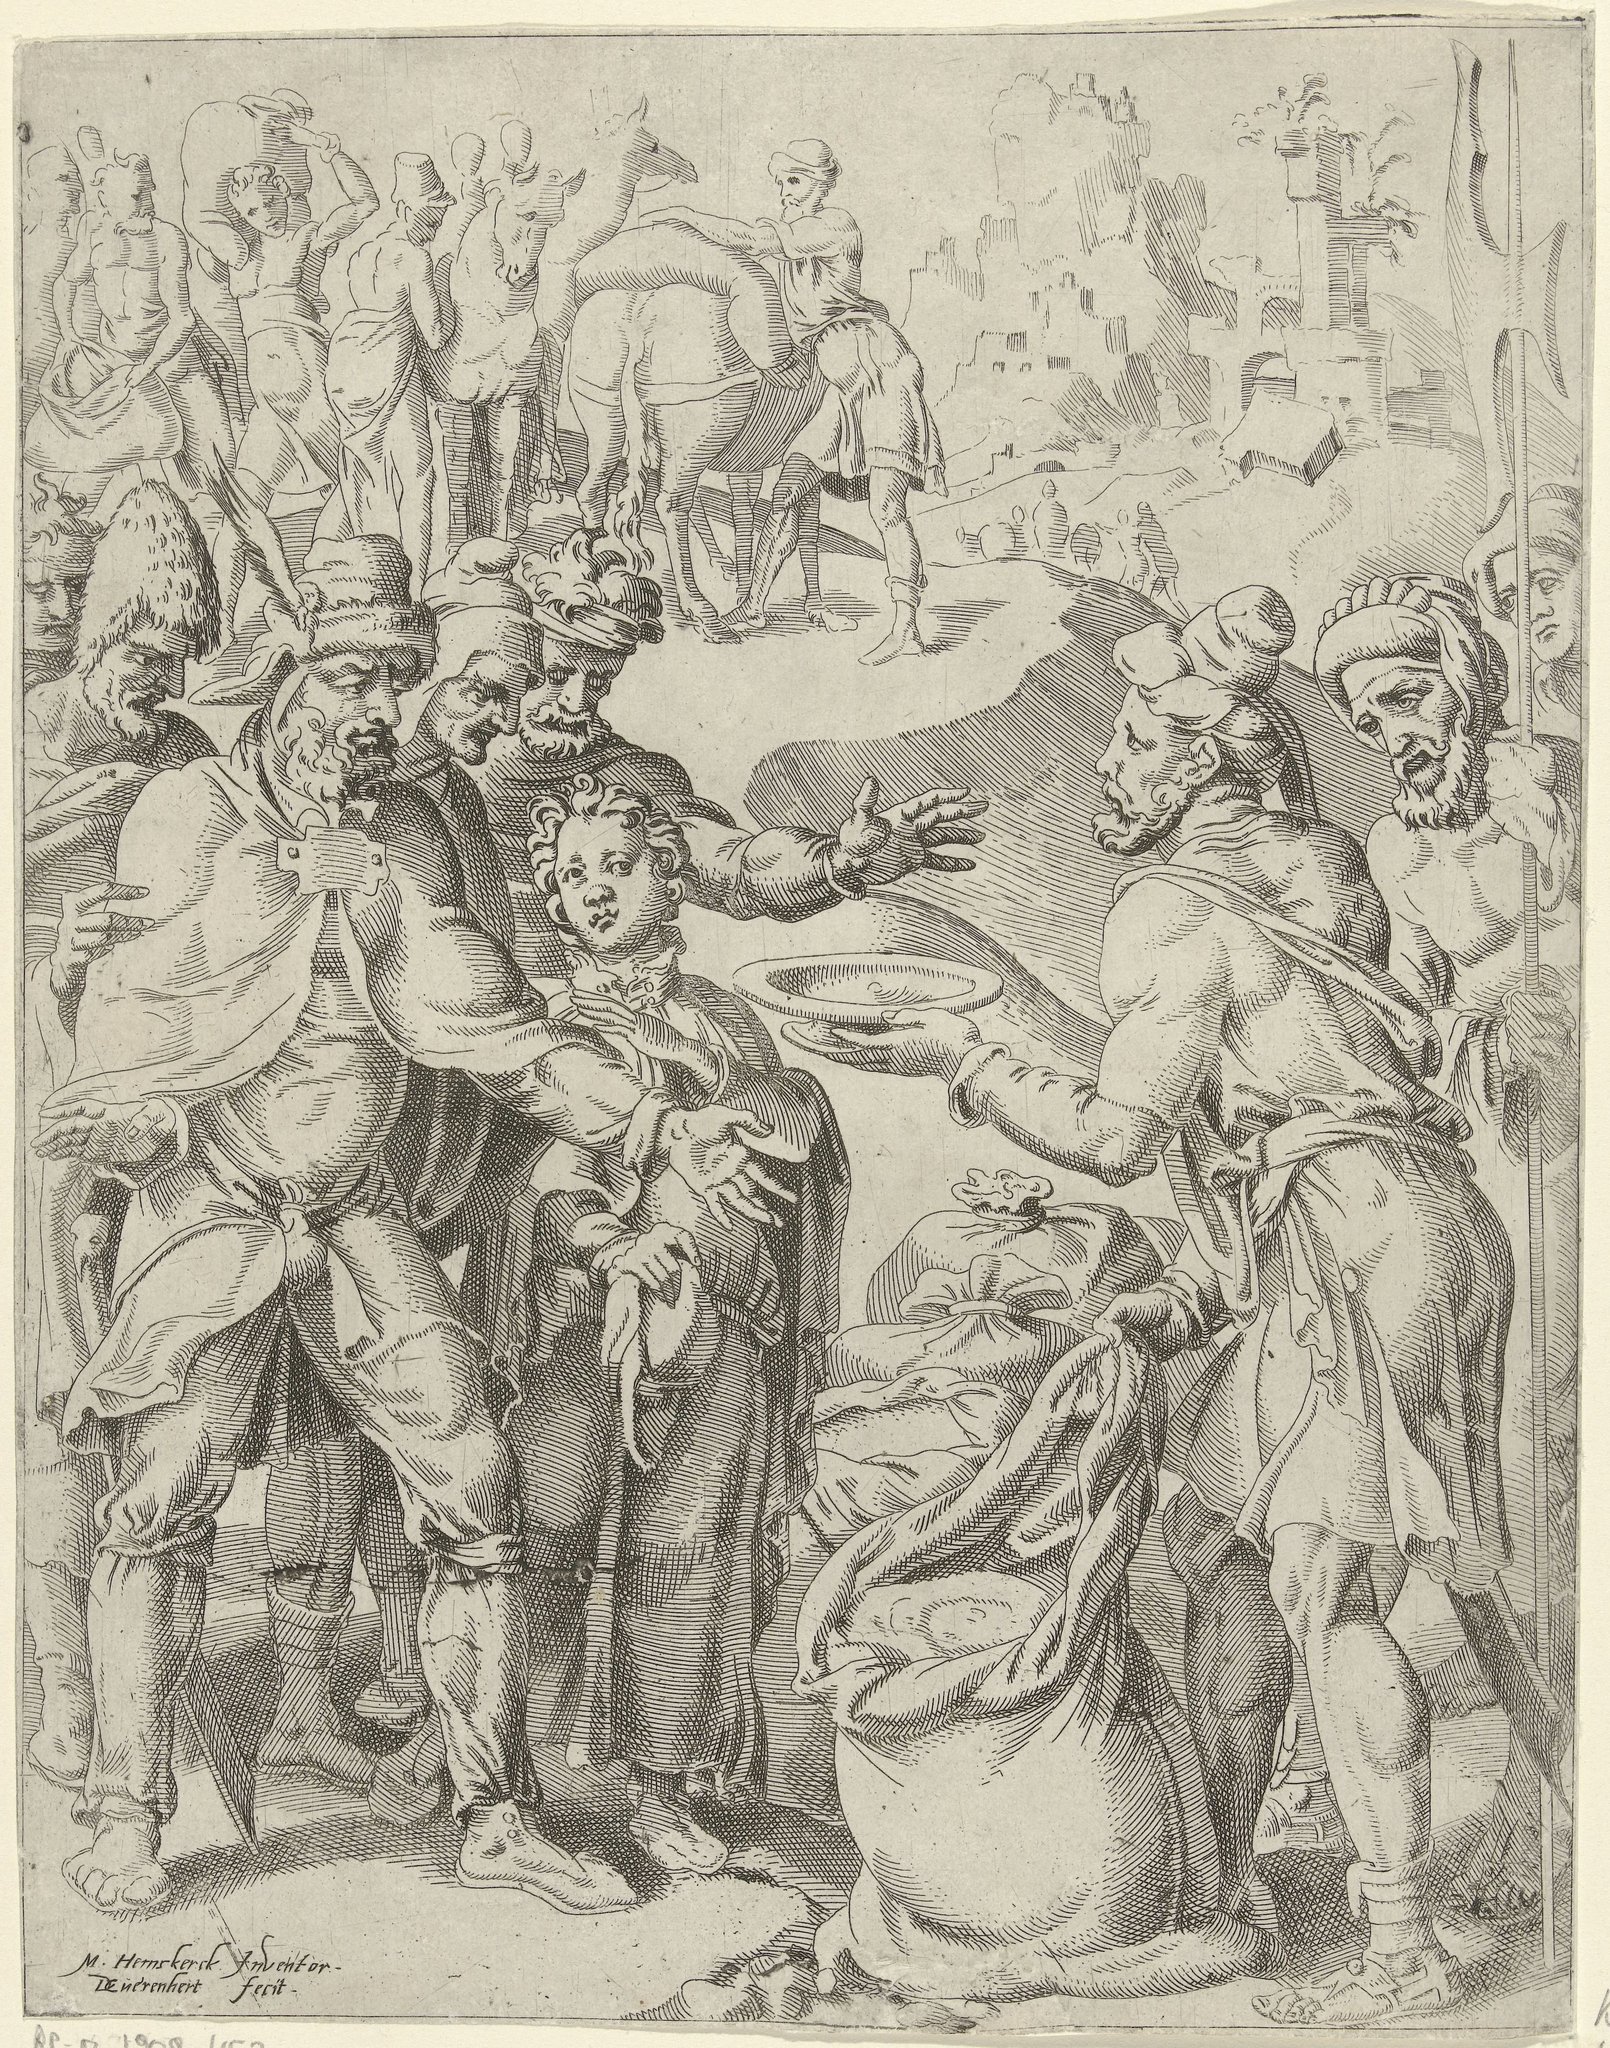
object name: print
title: Geschiedenis van Jozef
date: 1549-1550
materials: paper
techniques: etching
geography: haarlem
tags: the cup is found in benjamin's sack, joseph's brothers set out on their journey home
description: Op de achtergrond vertrekken de broers van Jozef terug naar huis, hun zakken vol koren. Op de voorgrond ontdekken Egyptische soldaten de zilveren beker die Jozef in de bagage van Benjamin heeft verstopt. De prent maakt deel uit van een serie over de geschidenis van Jozef